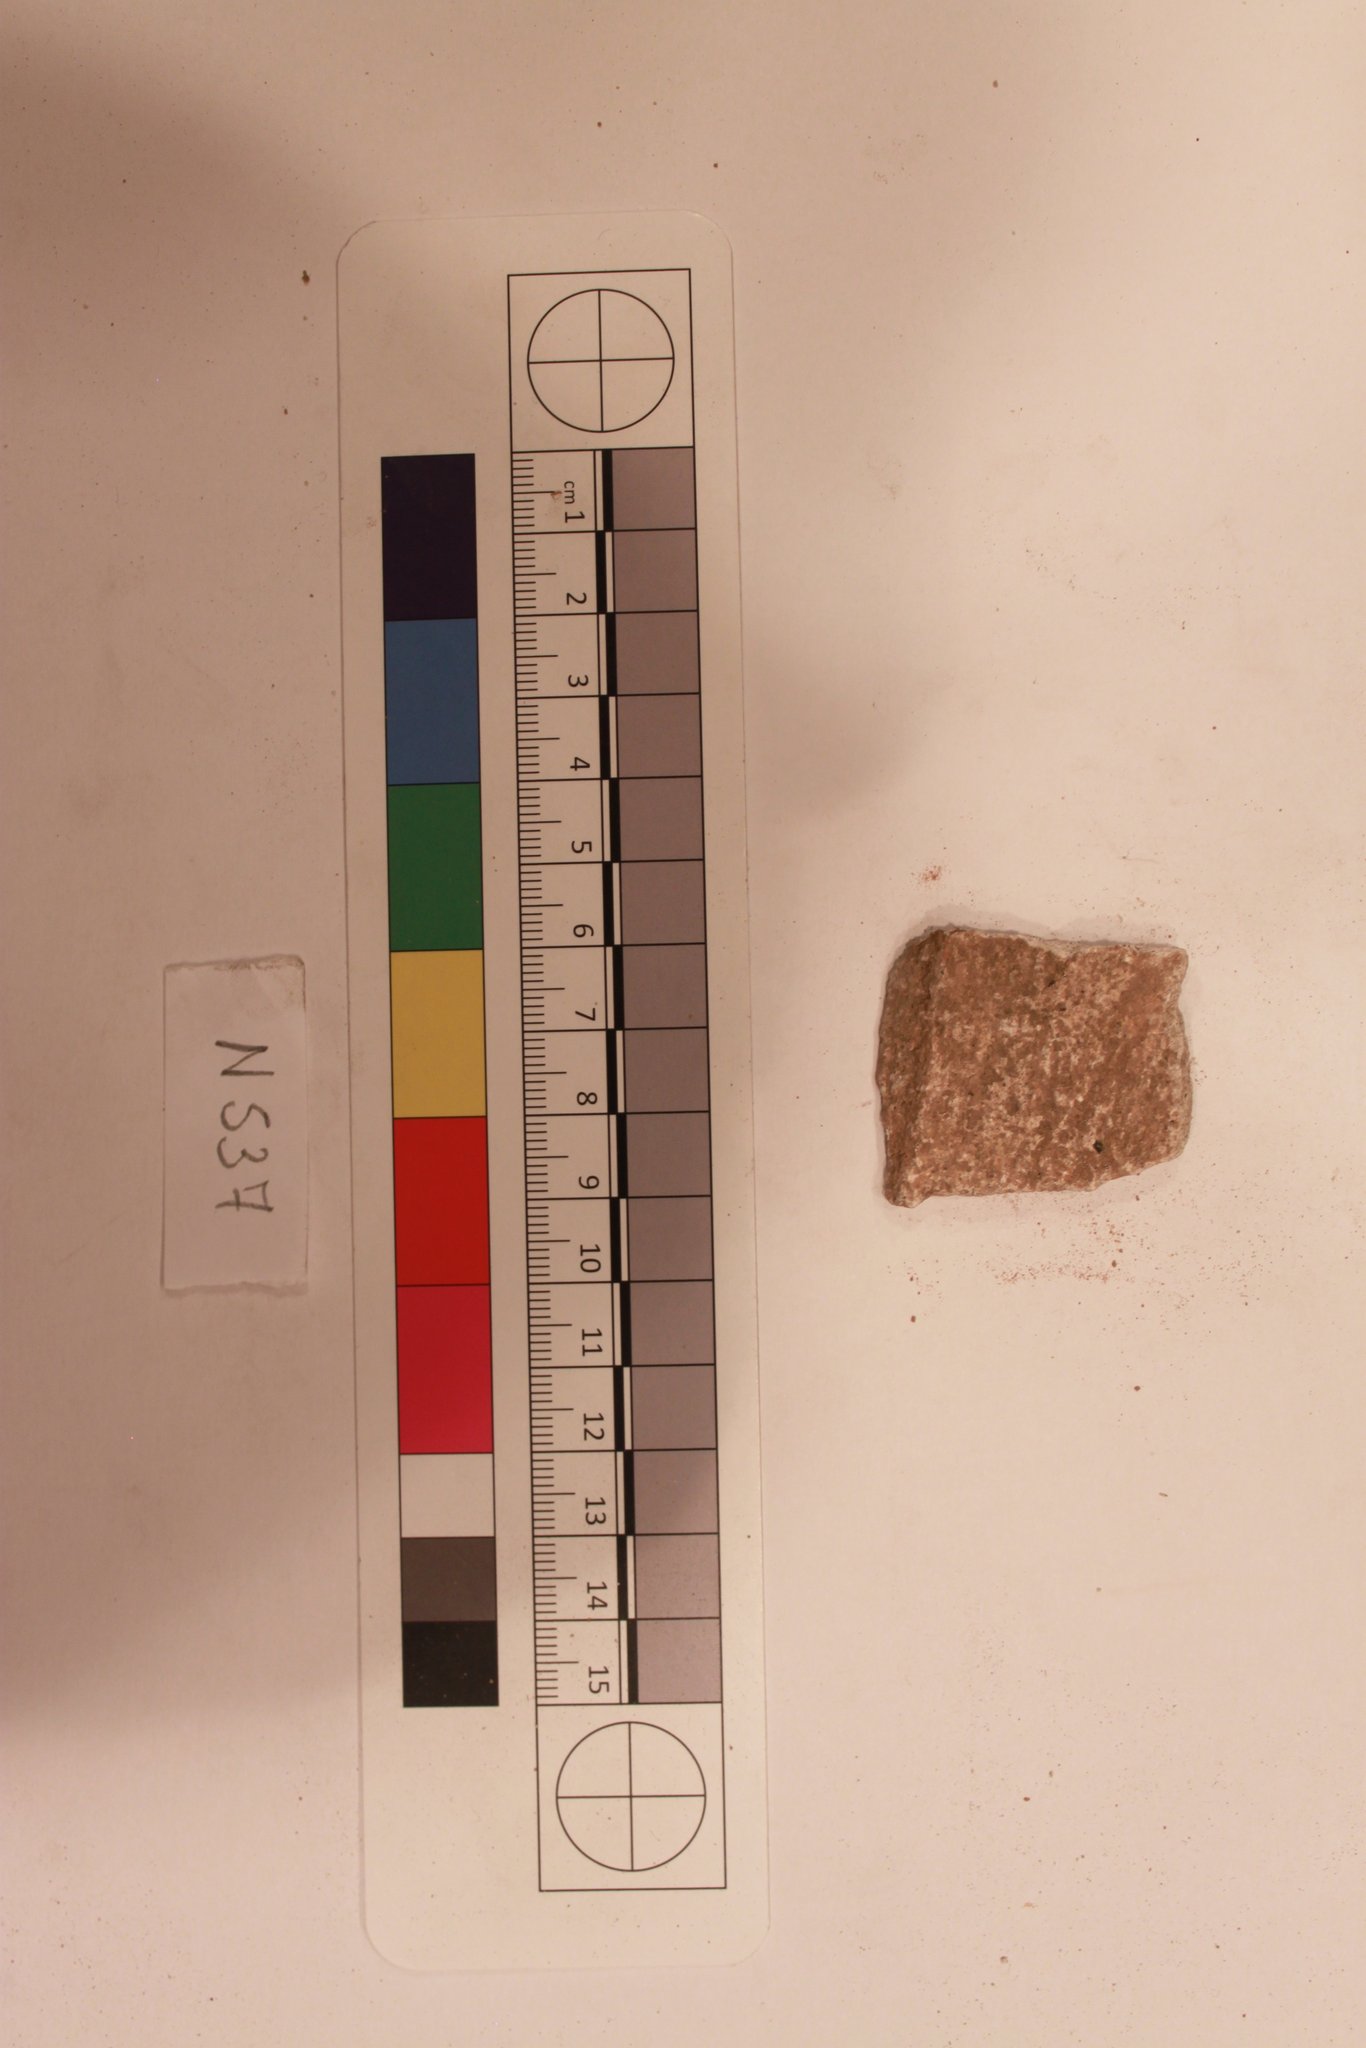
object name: fragment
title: Stucco Fragment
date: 701-1200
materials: plaster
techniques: carving, painting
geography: iran